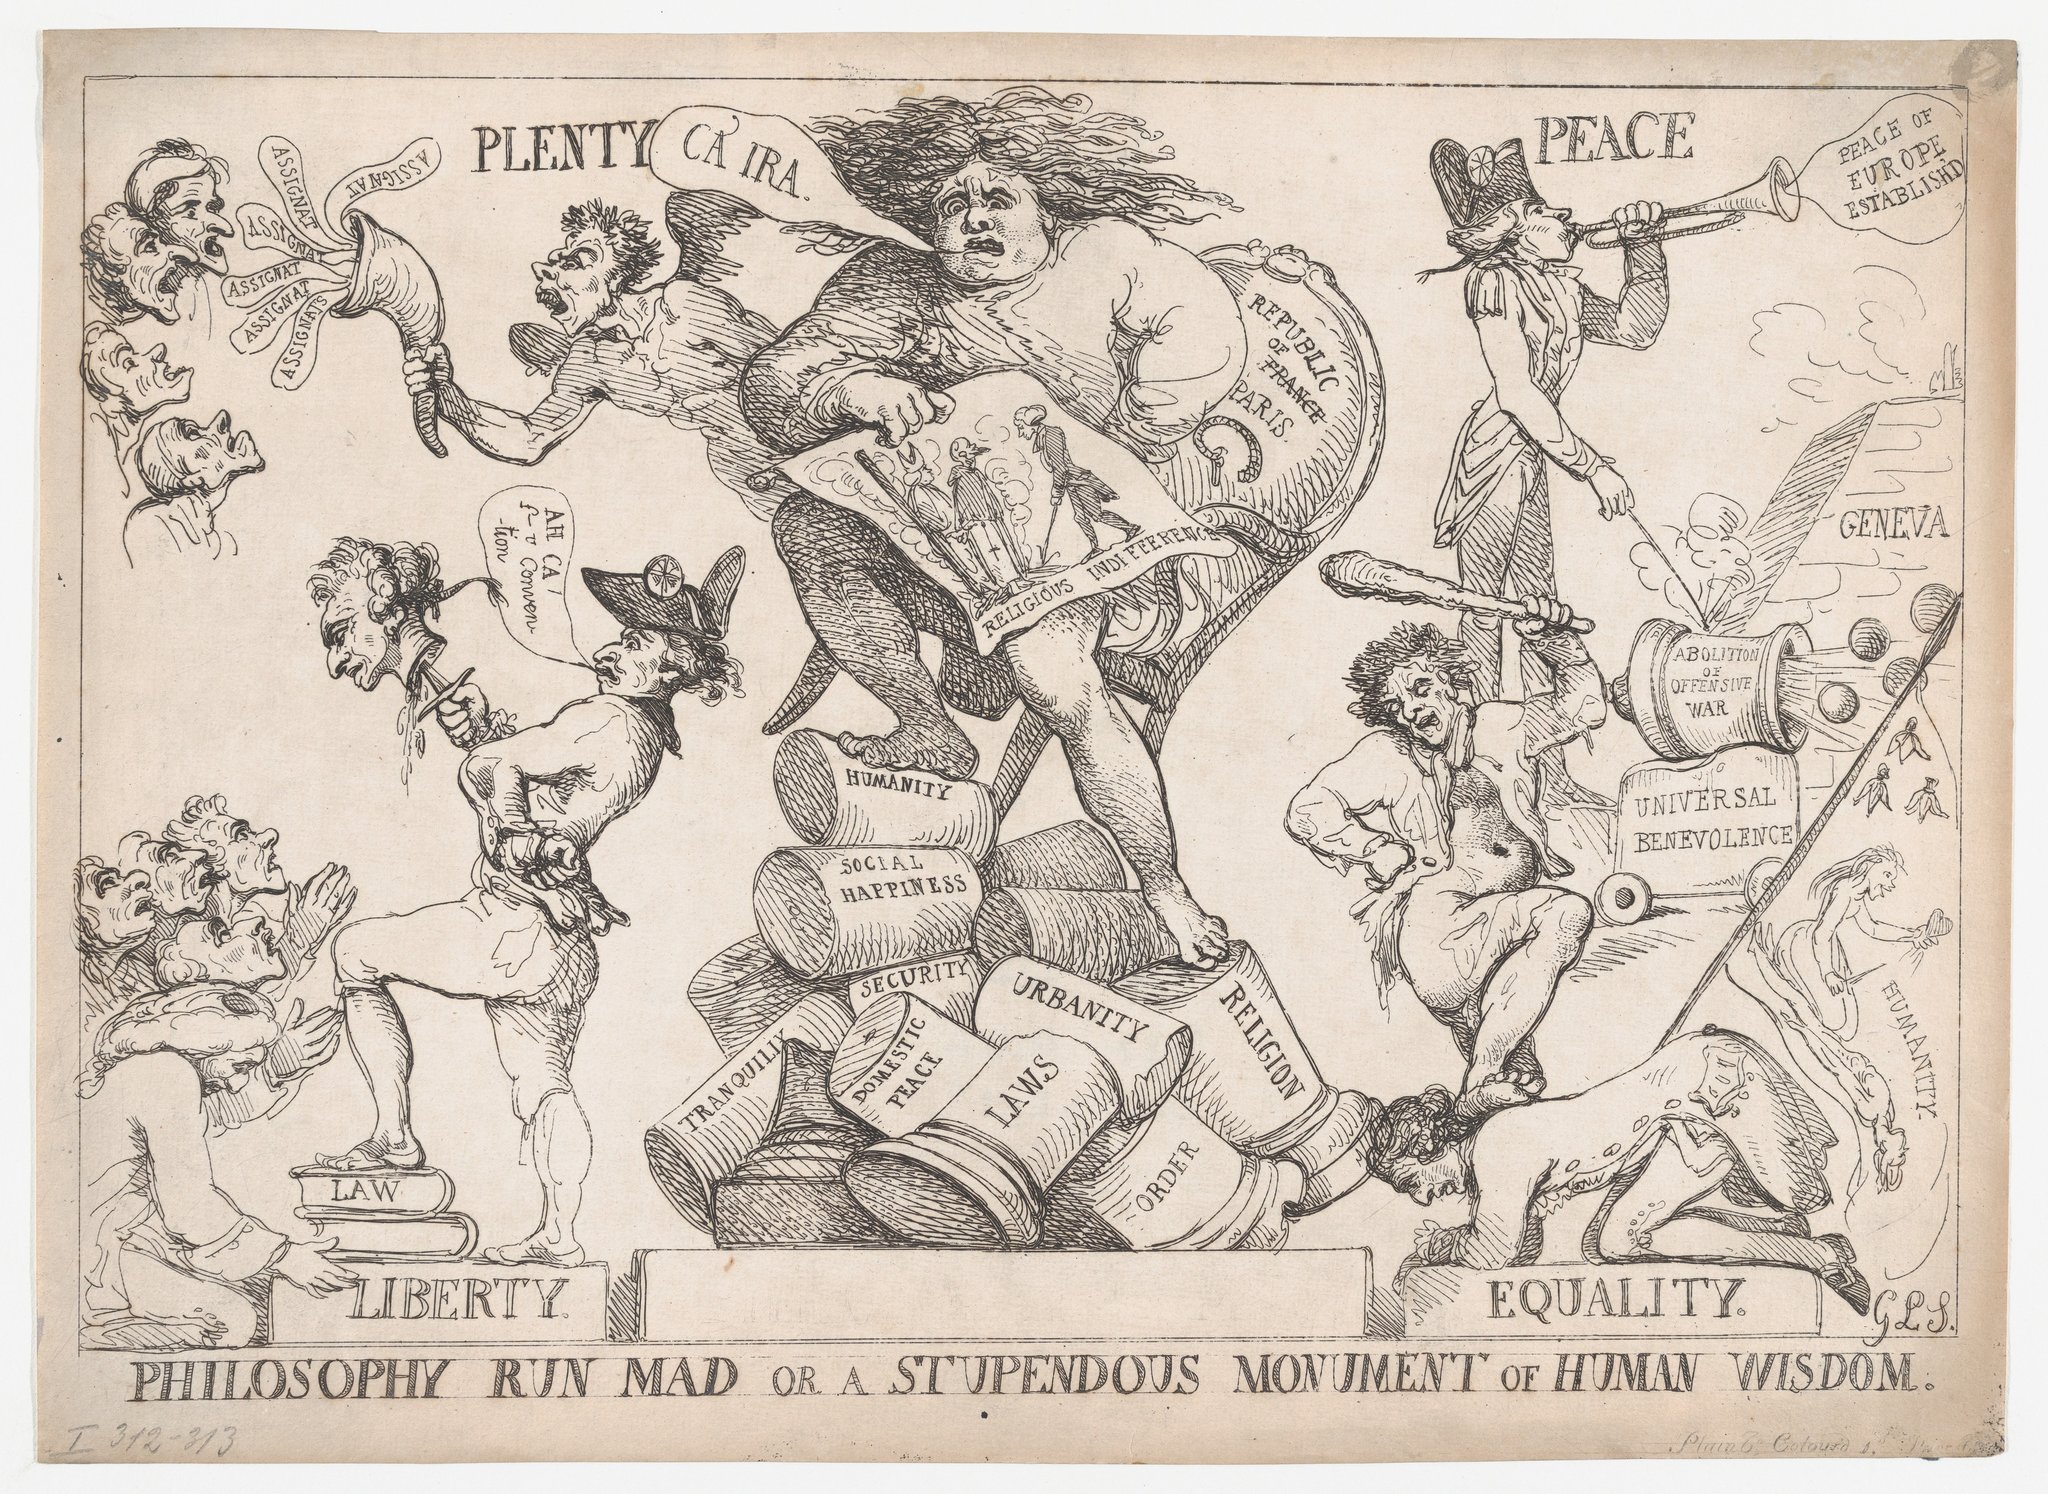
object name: print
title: Philosophy Run Mad or a Stupendous Monument of Human Wisdom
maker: thomas rowlandson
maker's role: artist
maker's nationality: british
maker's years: 1757-1827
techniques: etching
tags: musical instruments,satire,heads,men